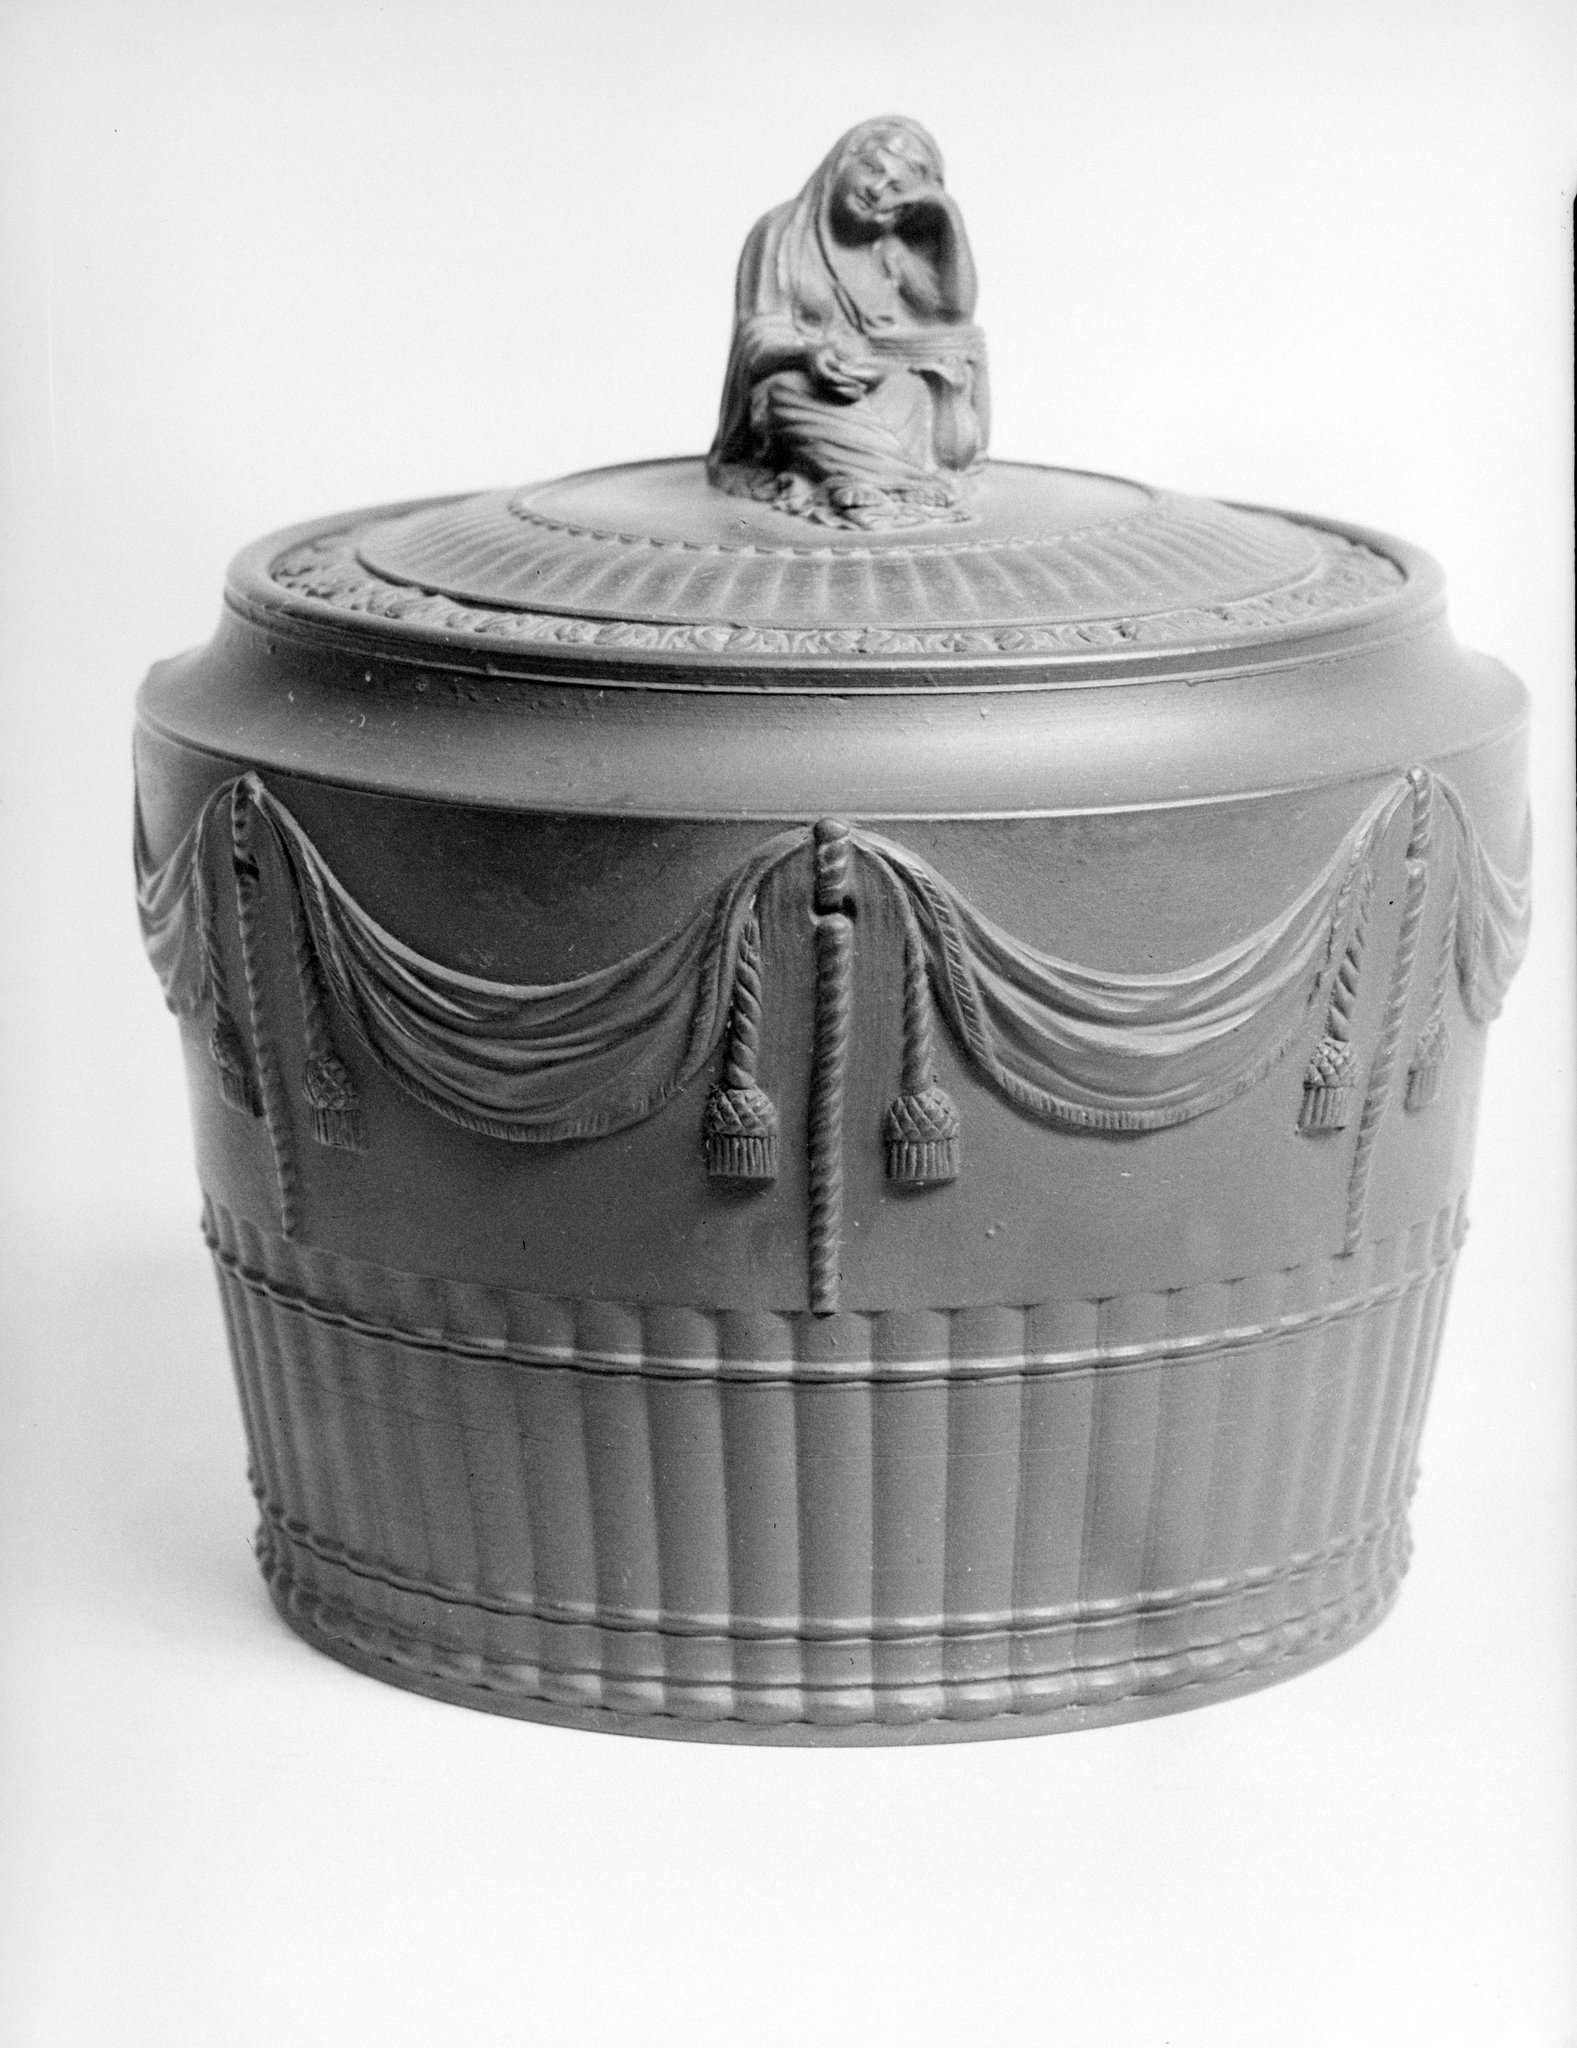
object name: bowl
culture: british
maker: e. j. neale and company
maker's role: maker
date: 1778-1786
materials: stone, earthenware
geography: england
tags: women